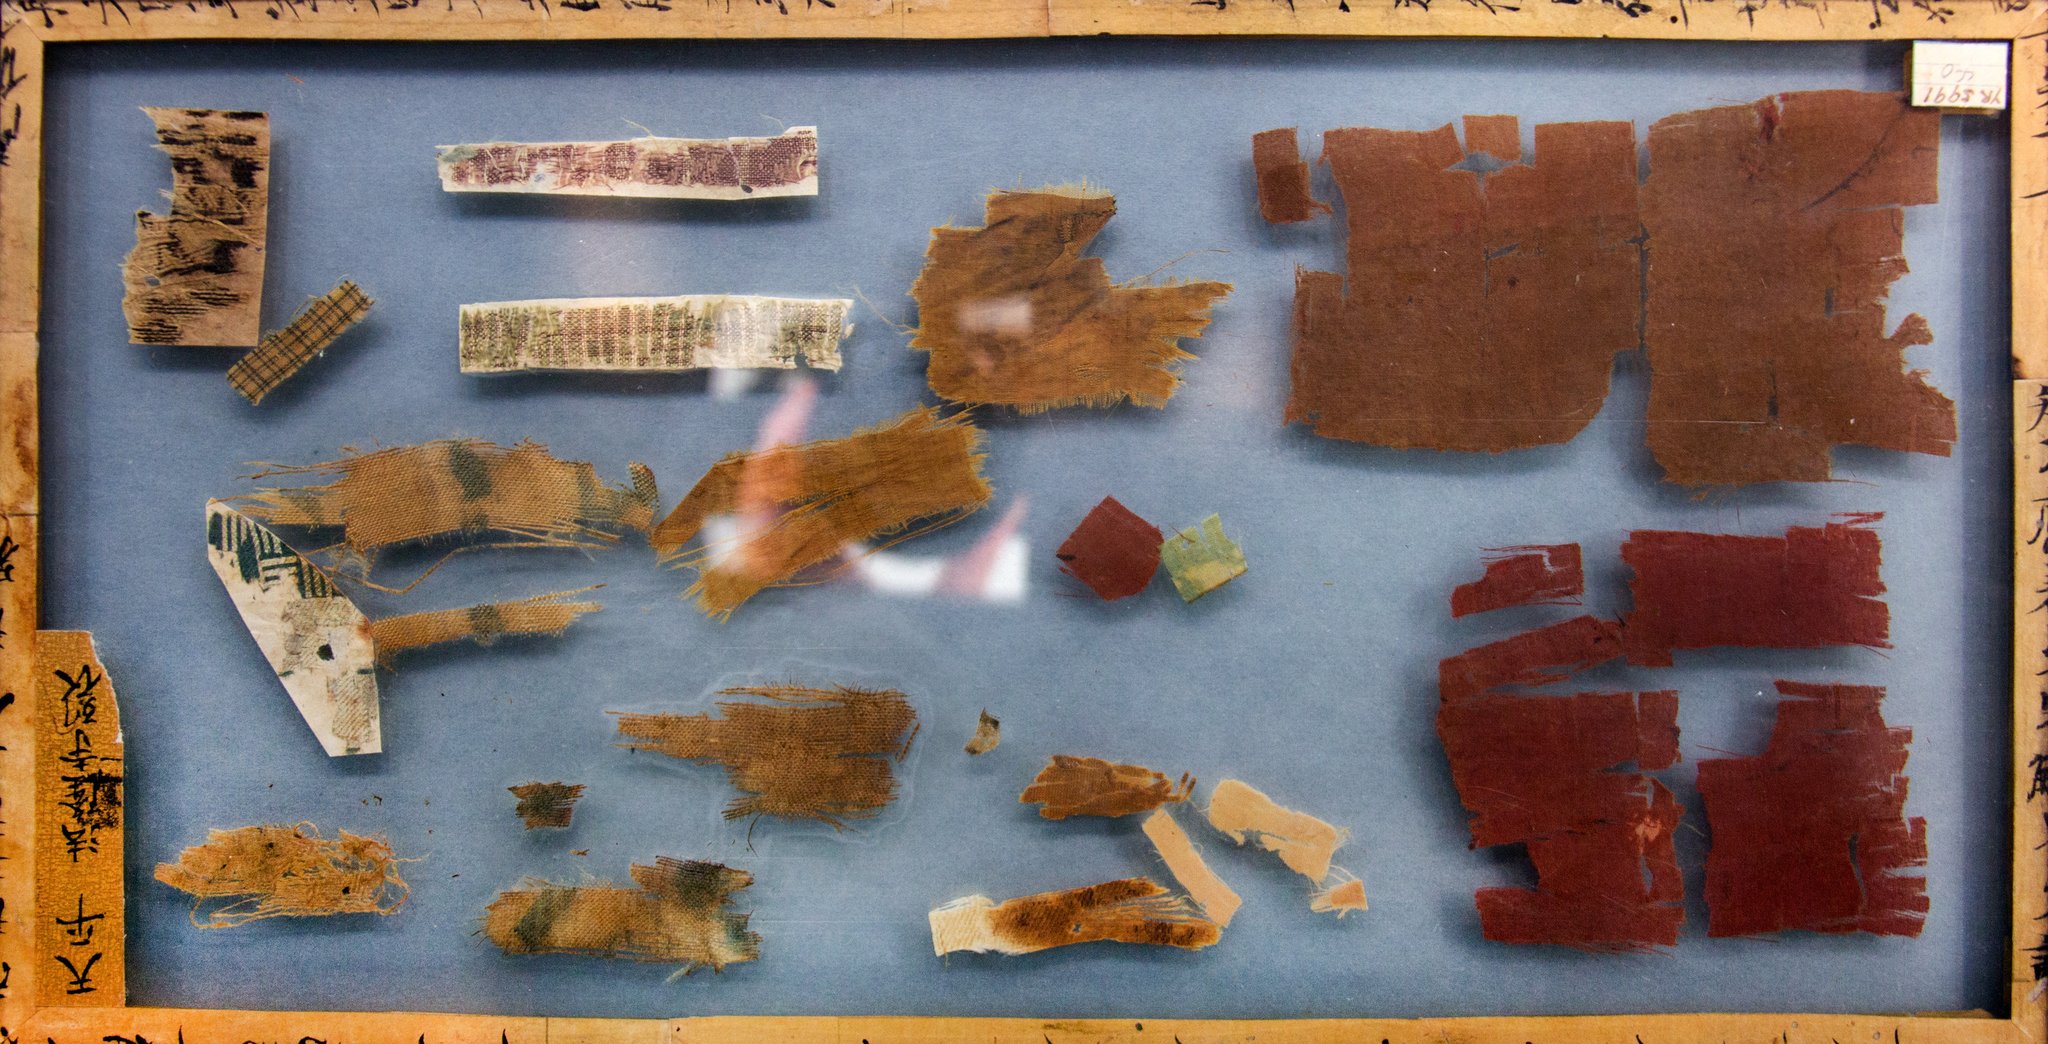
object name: fragment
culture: japanese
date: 701-800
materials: cotton, linen, silk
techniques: weave